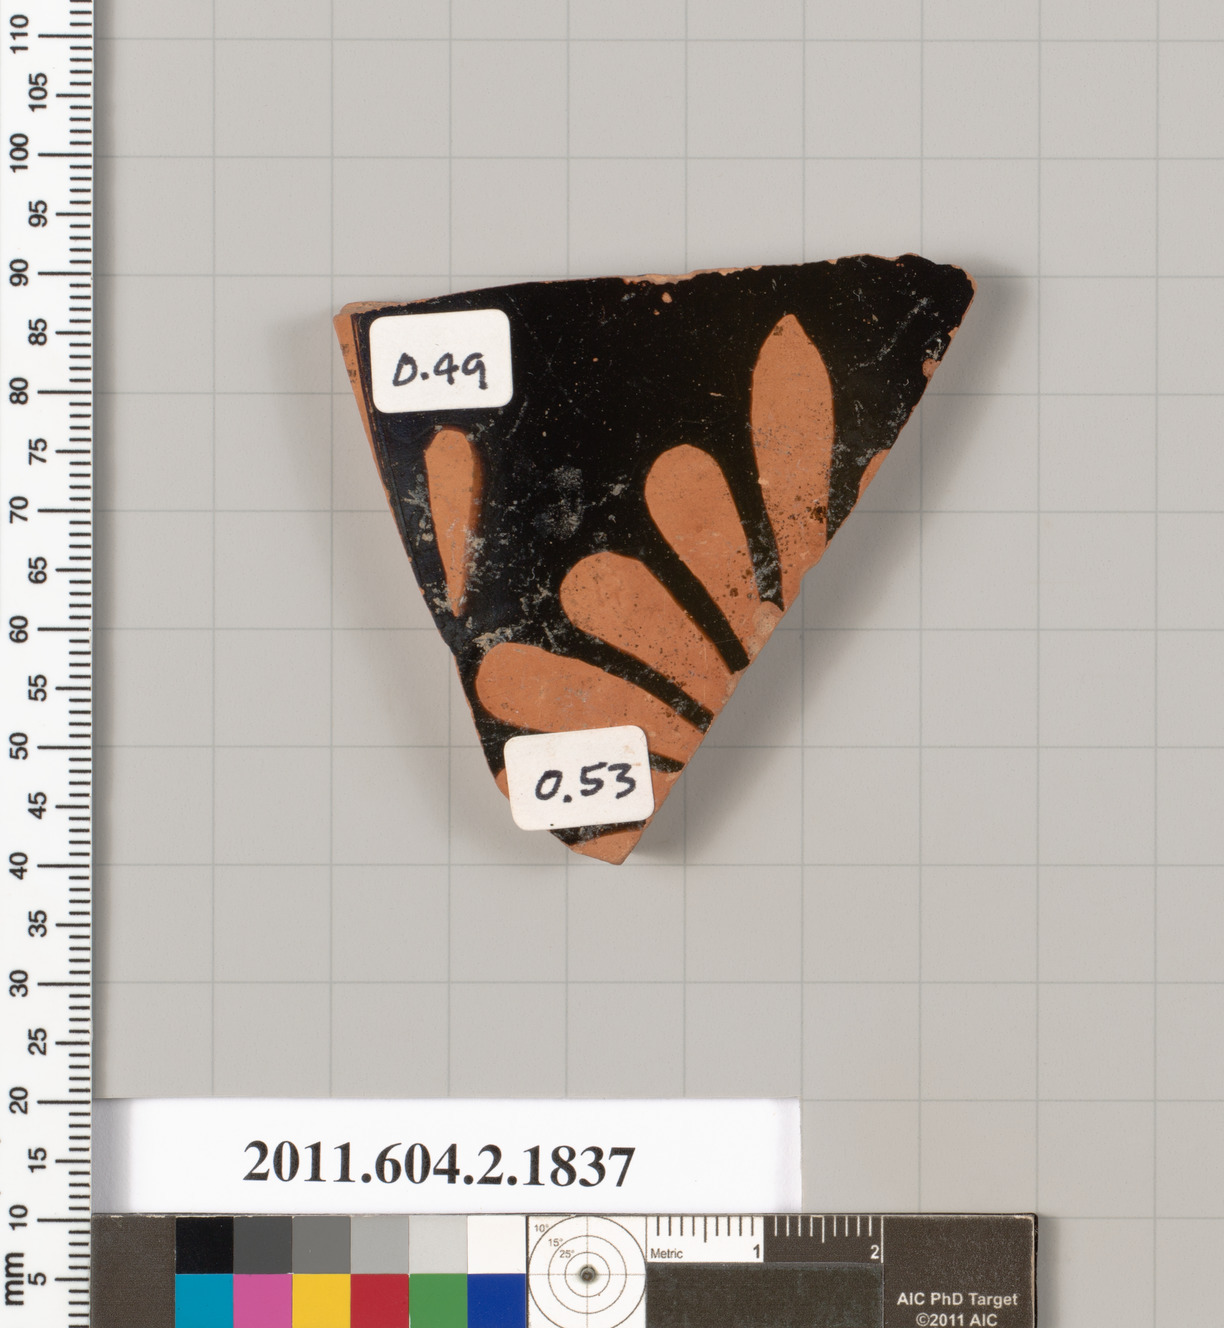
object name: skyphos fragment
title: Terracotta fragment of a skyphos (deep drinking cup)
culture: greek, attic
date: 450-426 BCE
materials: terracotta